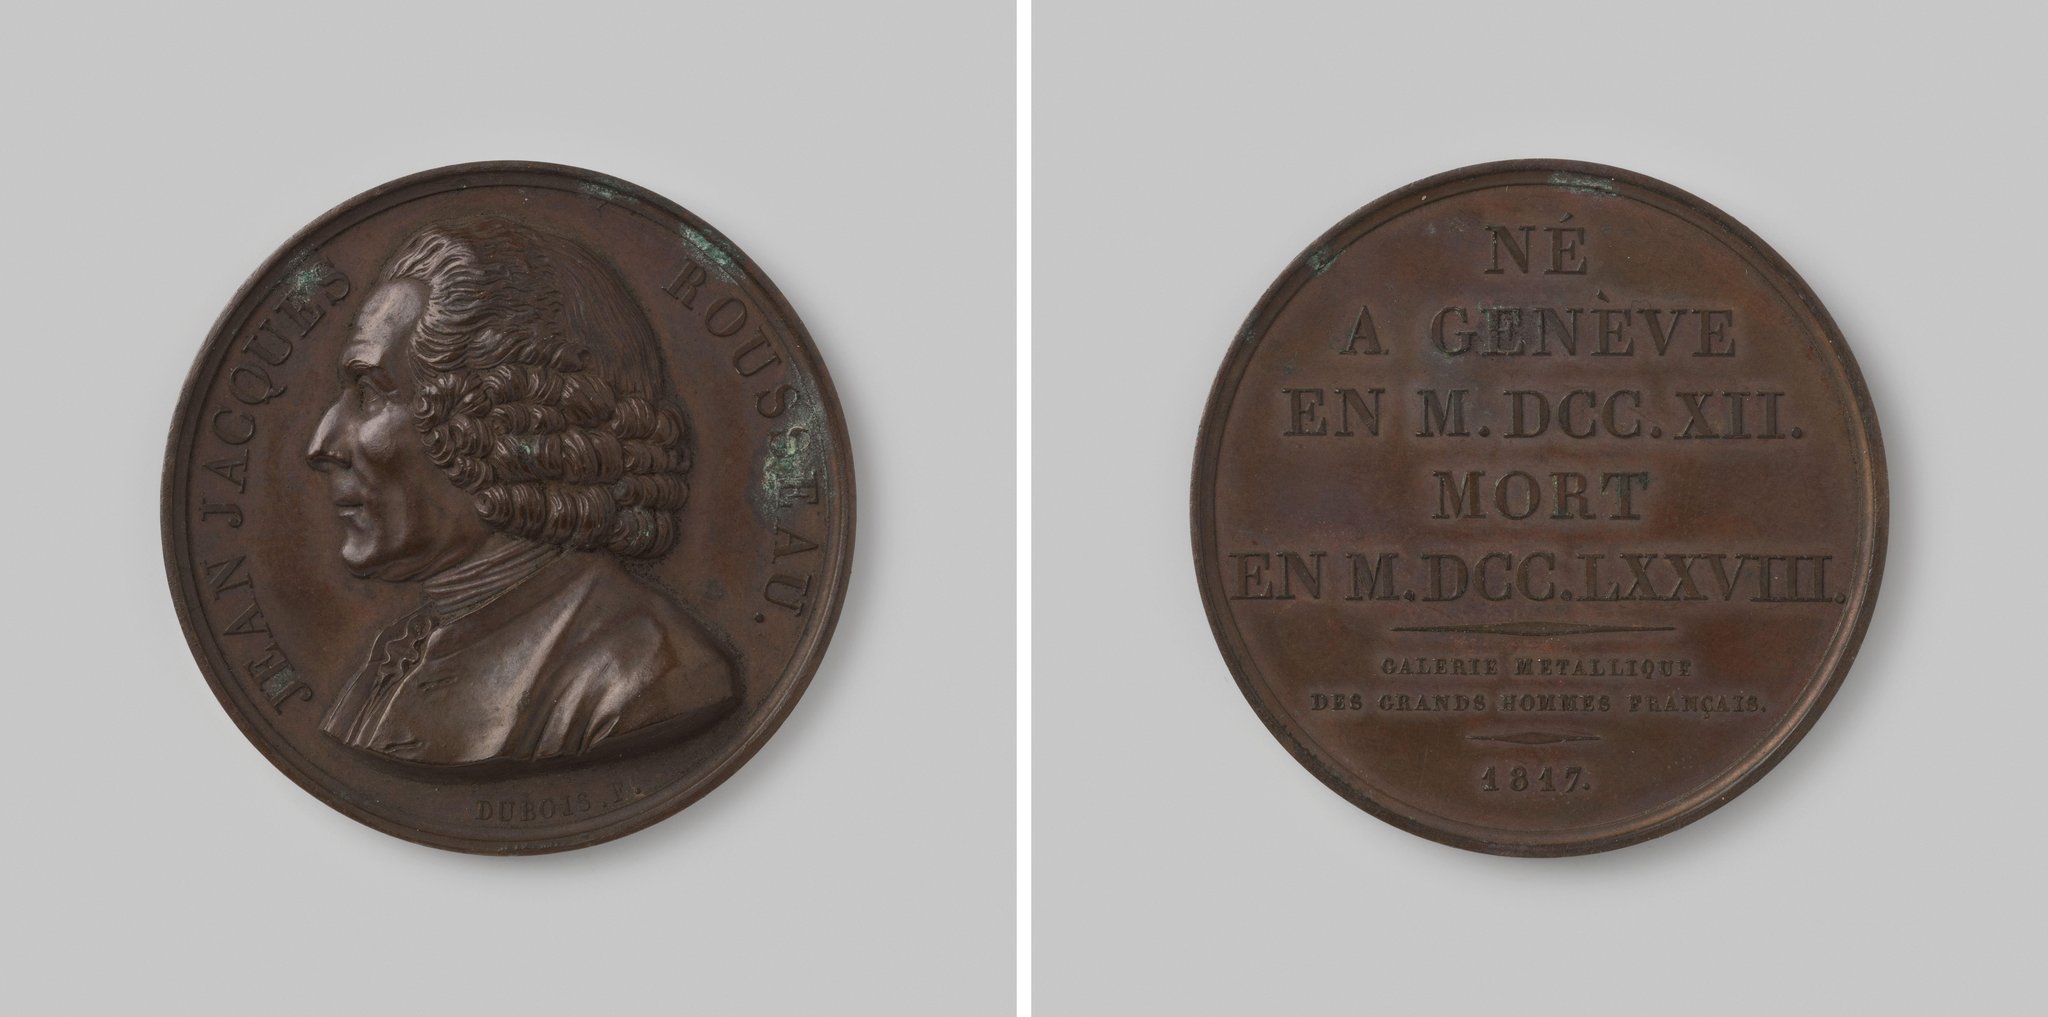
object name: history medal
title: Grands Hommes Français - Jean Jacques Rousseau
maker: dubois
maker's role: draughtsman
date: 1816-1838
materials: bronze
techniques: striking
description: Bronzen penning, op de voorzijde het borstbeeld van Rousseau naar links met omschrift, op de keerzijde acht regels tekst.